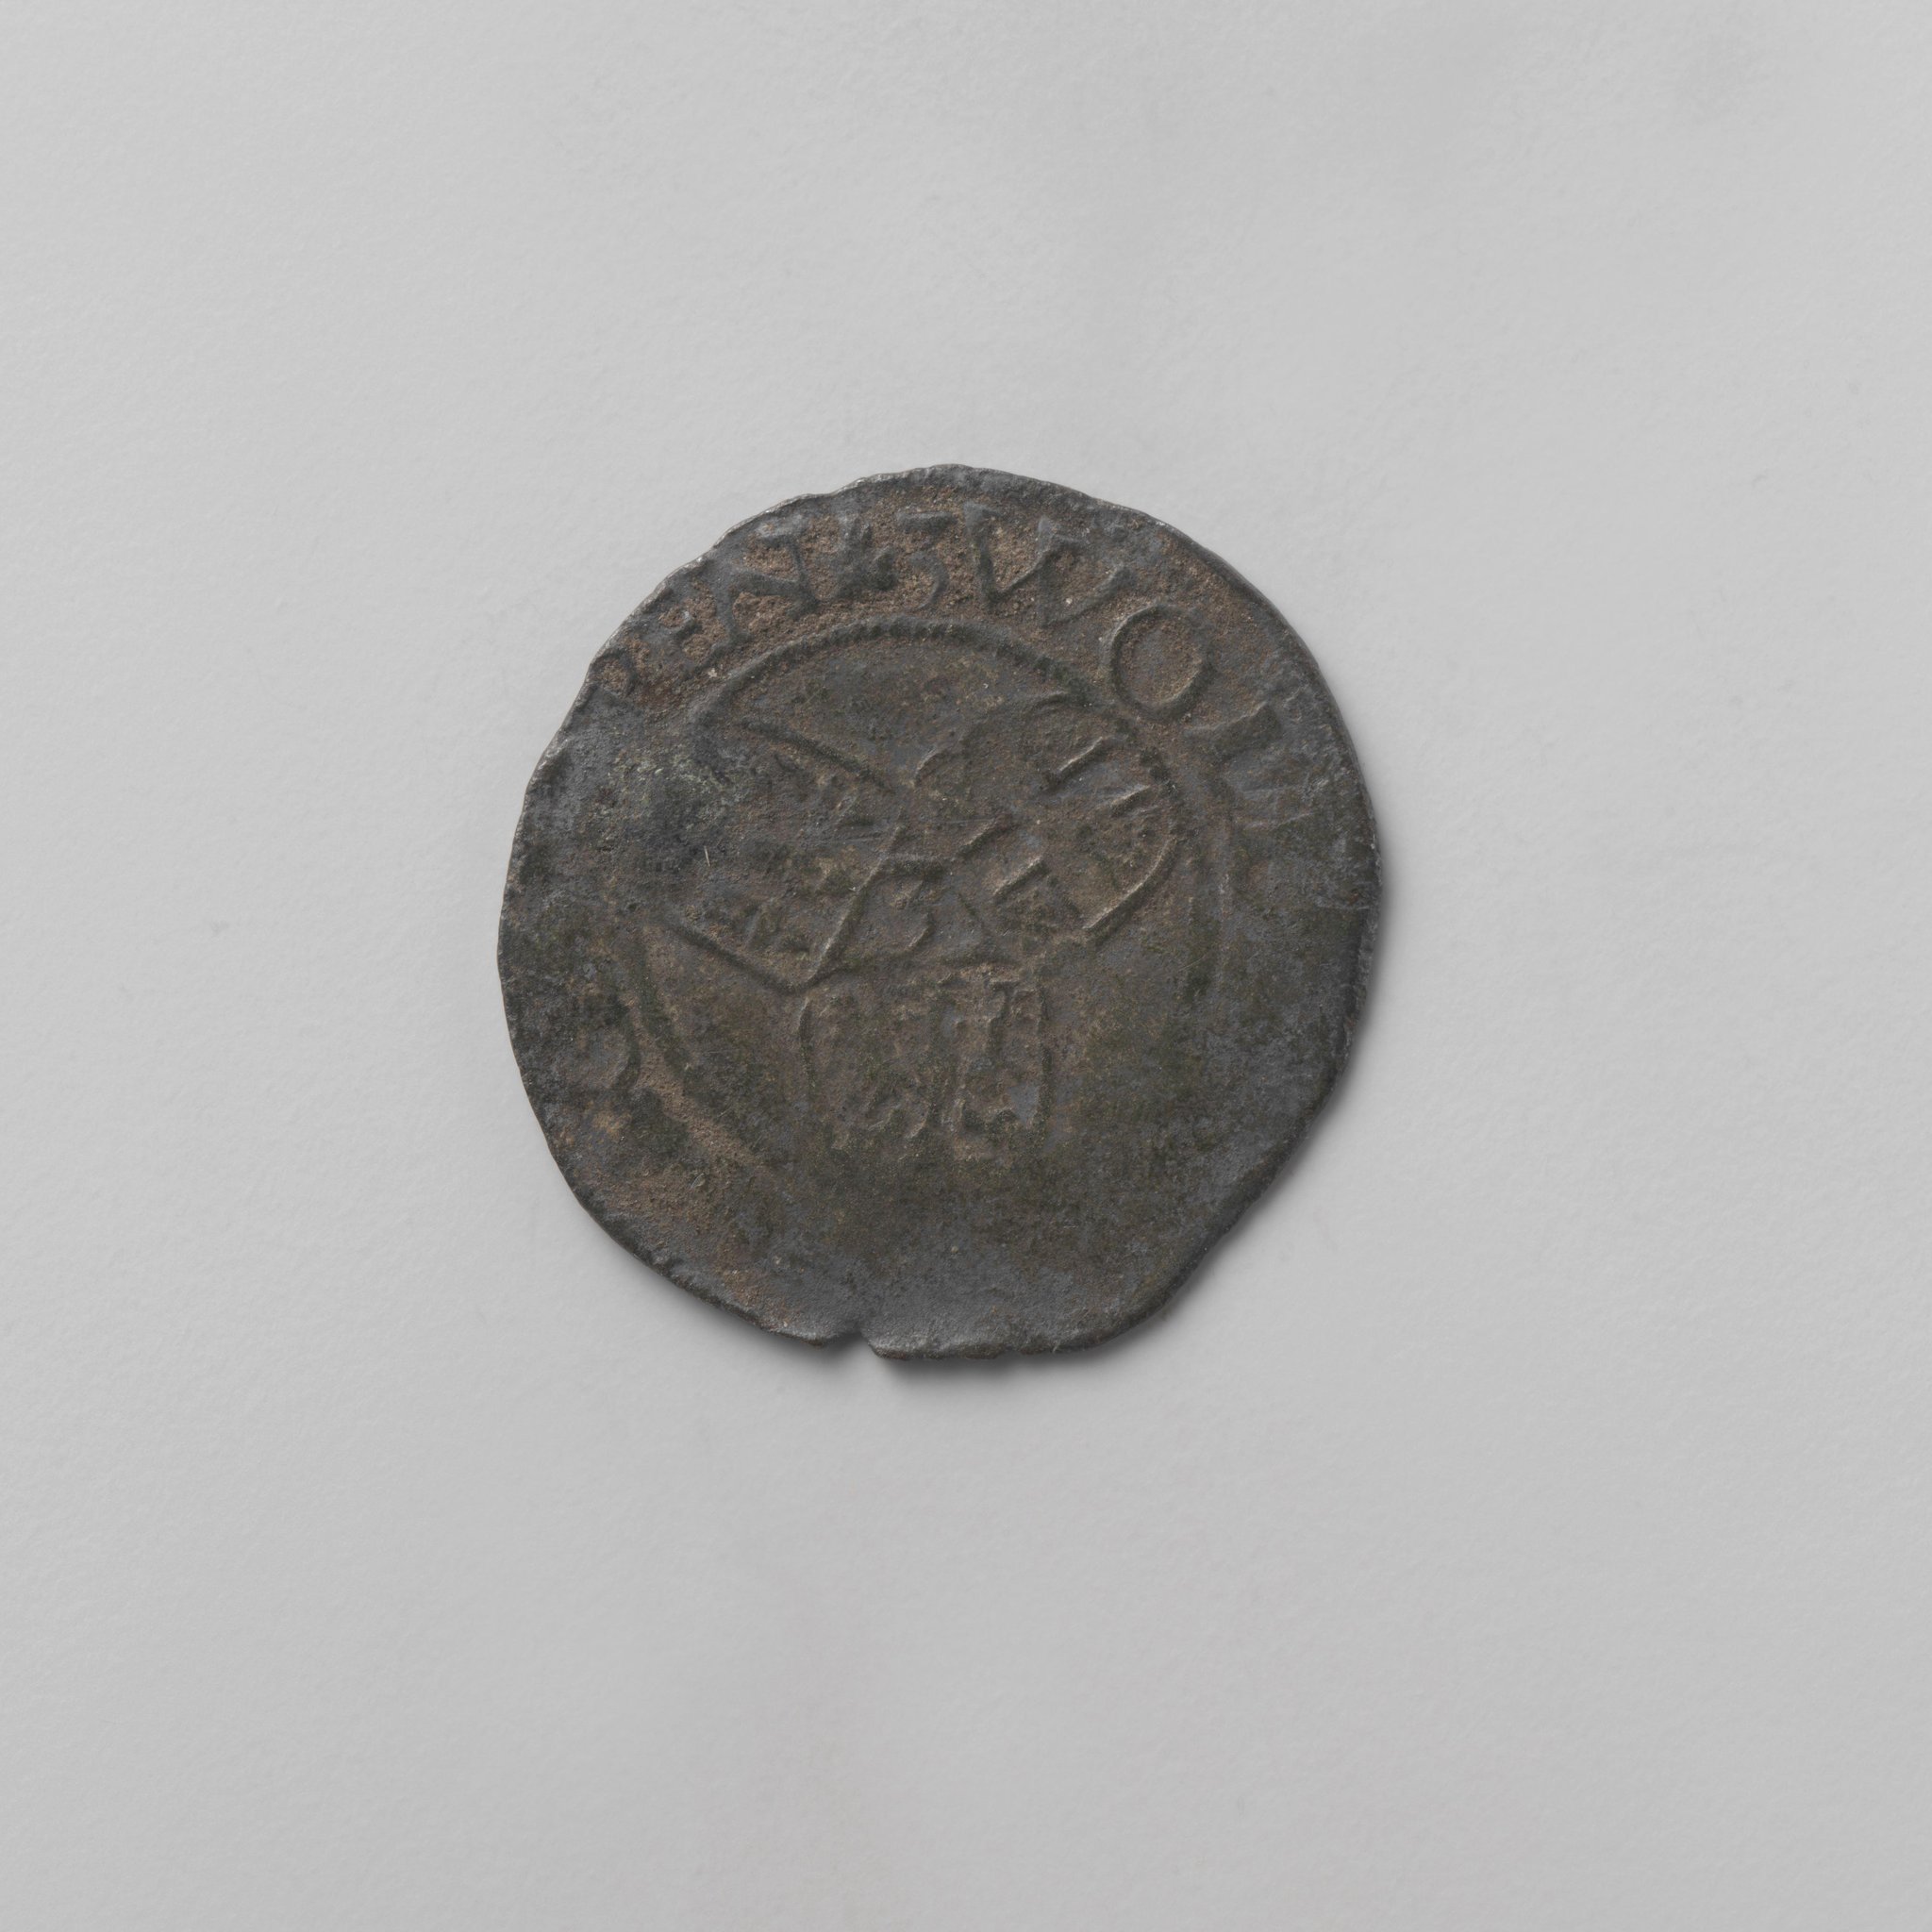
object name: coin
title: Drieplak van de Drie Steden, 1556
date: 1556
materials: silver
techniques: striking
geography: deventer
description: Koper-zilveren munt. Voorzijde: Versierd lang kruis, in het centrum cijfer 3, in de hoeken roosjes. Jaartal 56 in omschrift. Keerzijde: wapenschildjes van de Drie Steden, in het centrum cijfer 3.